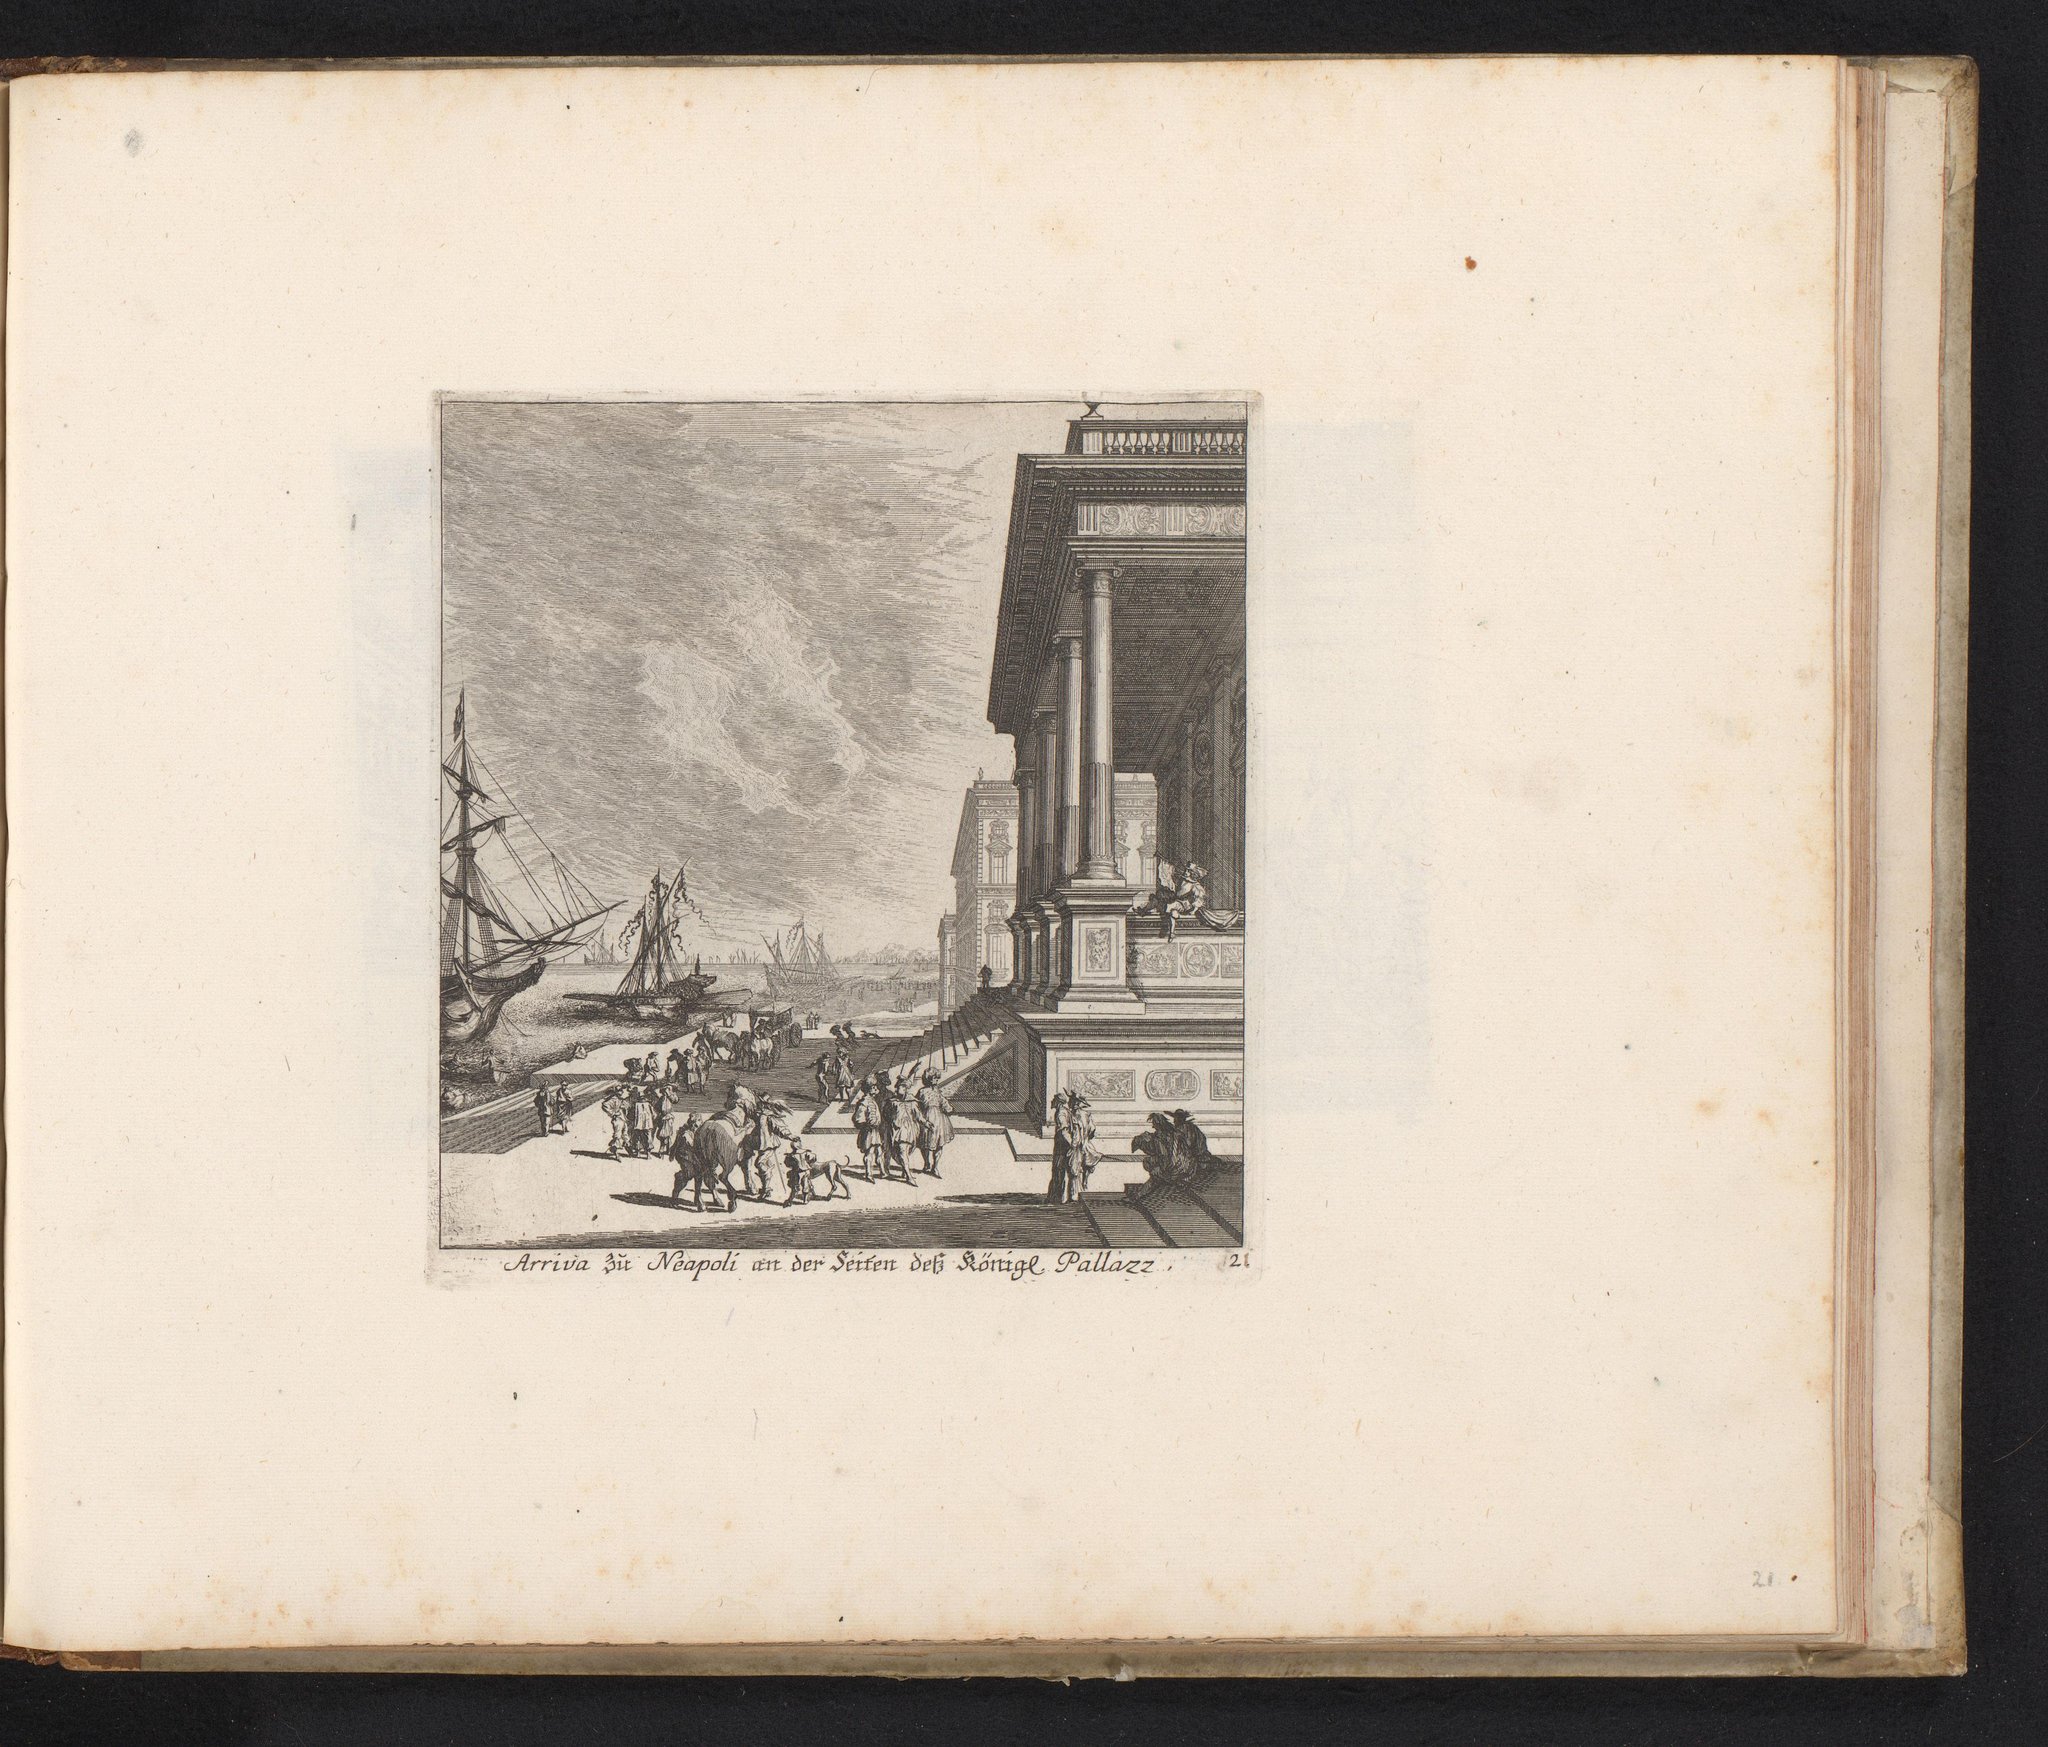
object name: print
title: Werf bij het koninklijk paleis in Napels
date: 1670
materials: paper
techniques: etching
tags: pier, quay, wharf (+ four persons or more ~ traffic and transport), palace, naples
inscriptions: collector's mark: Lugt 2228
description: Tekst in het Duits in de ondermarge. Rechtsonder genummerd: 21. Prent maakt deel uit van een album.